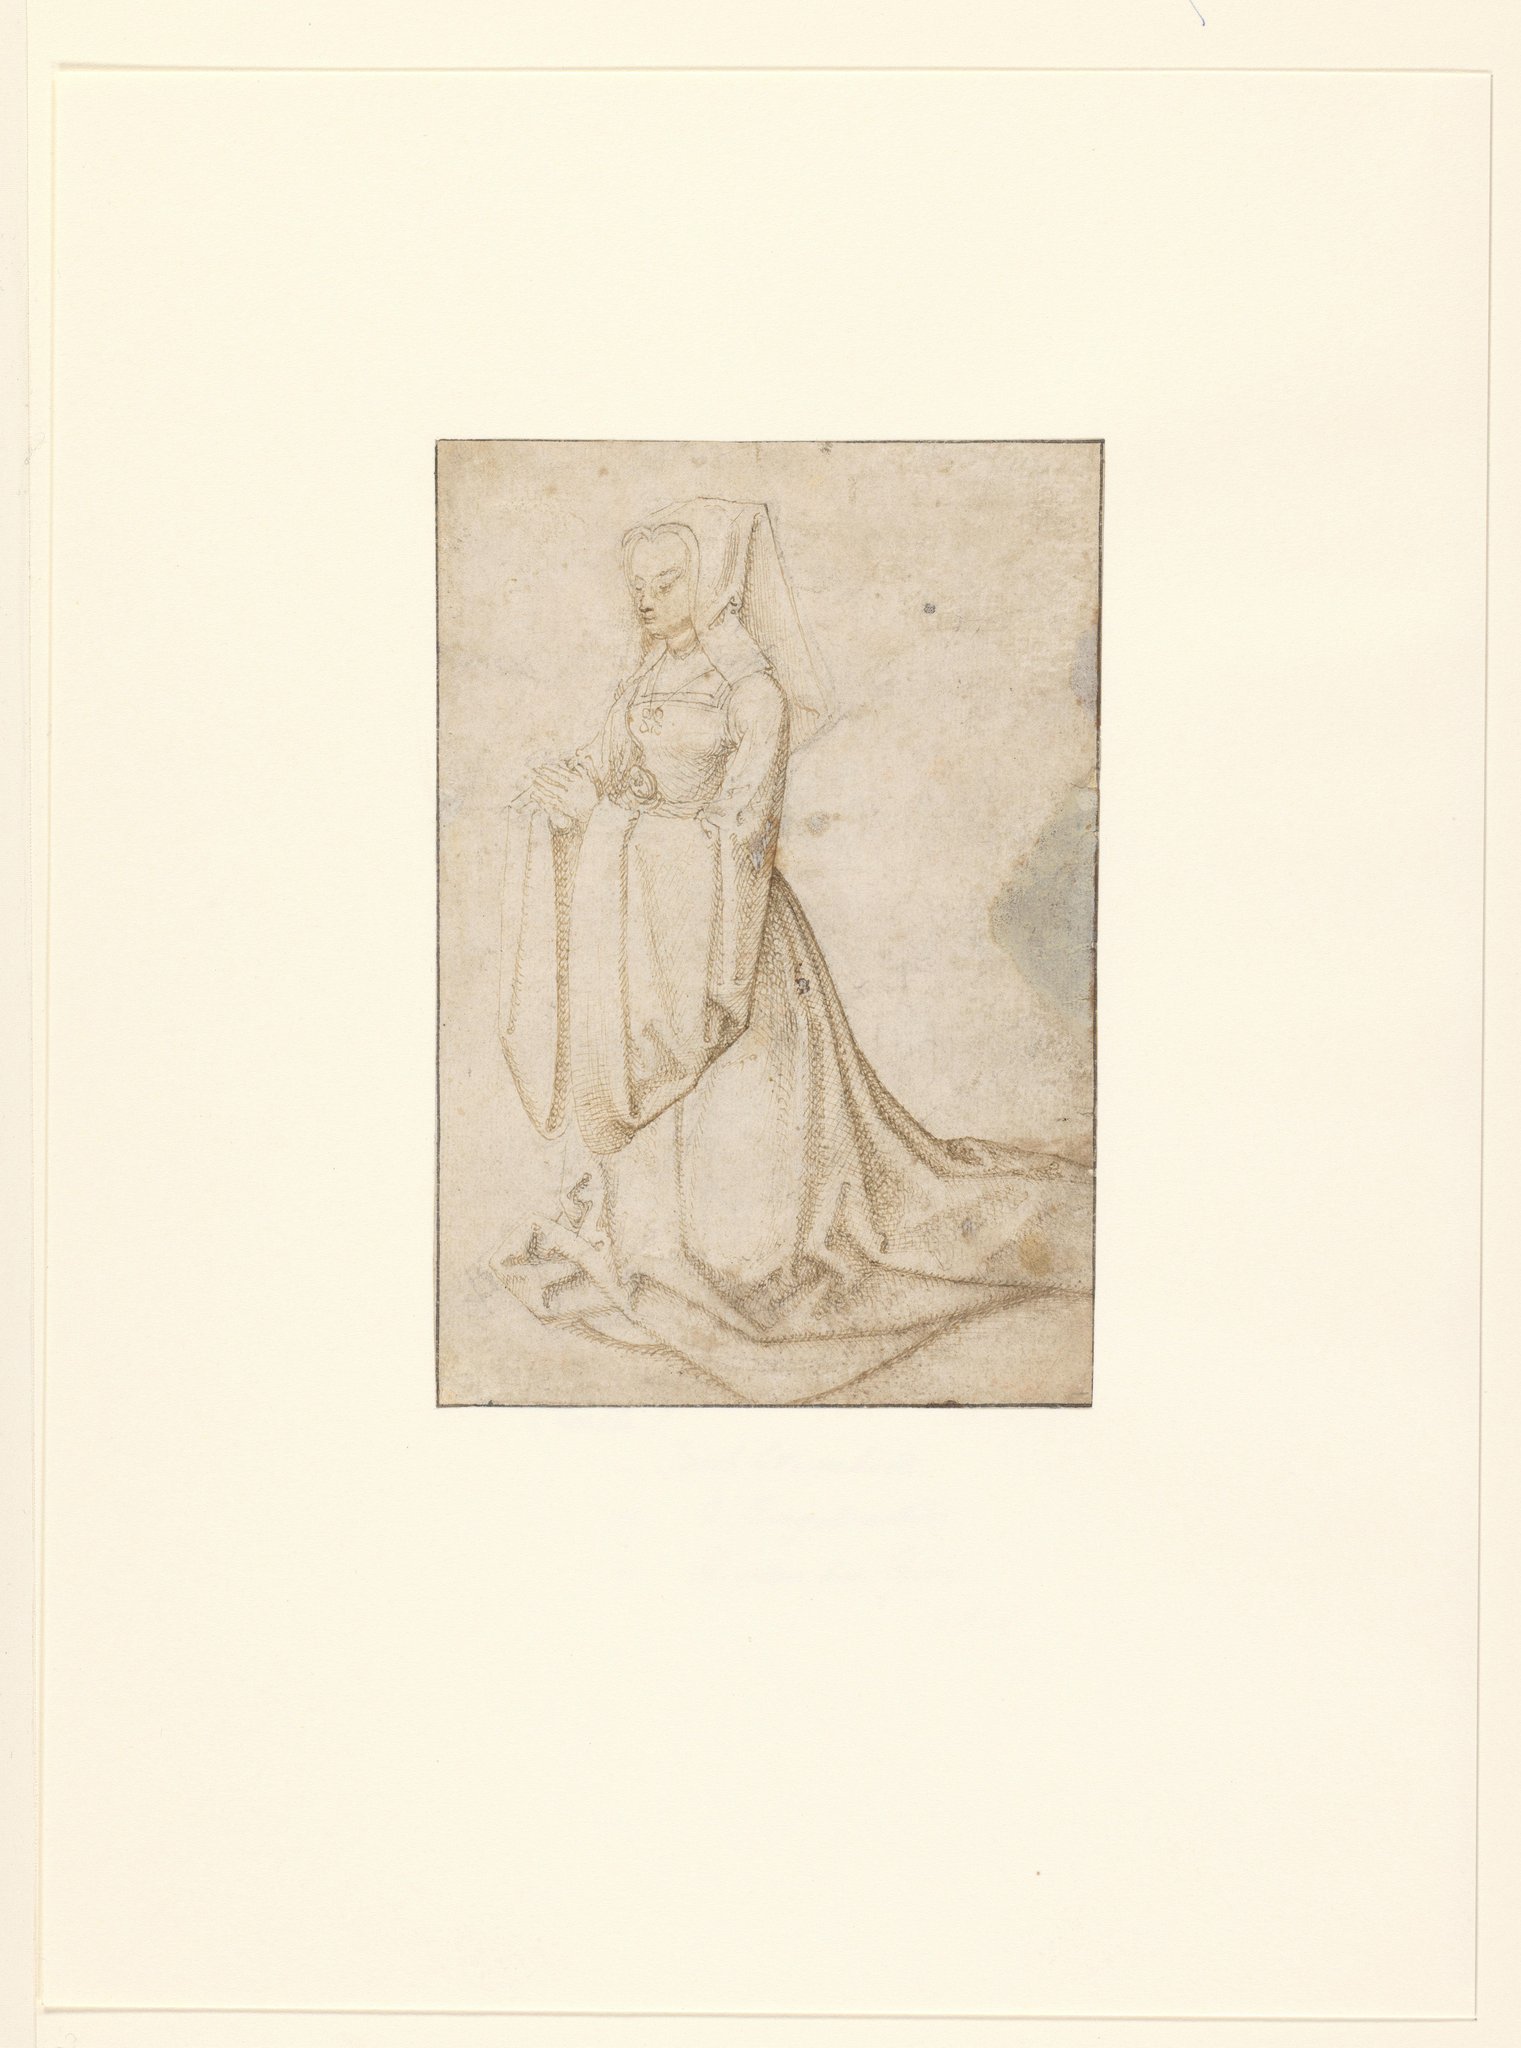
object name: drawing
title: Vrouwelijke stichter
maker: Anonymous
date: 1500-1524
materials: ink, paper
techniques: brush, pen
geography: southern netherlands